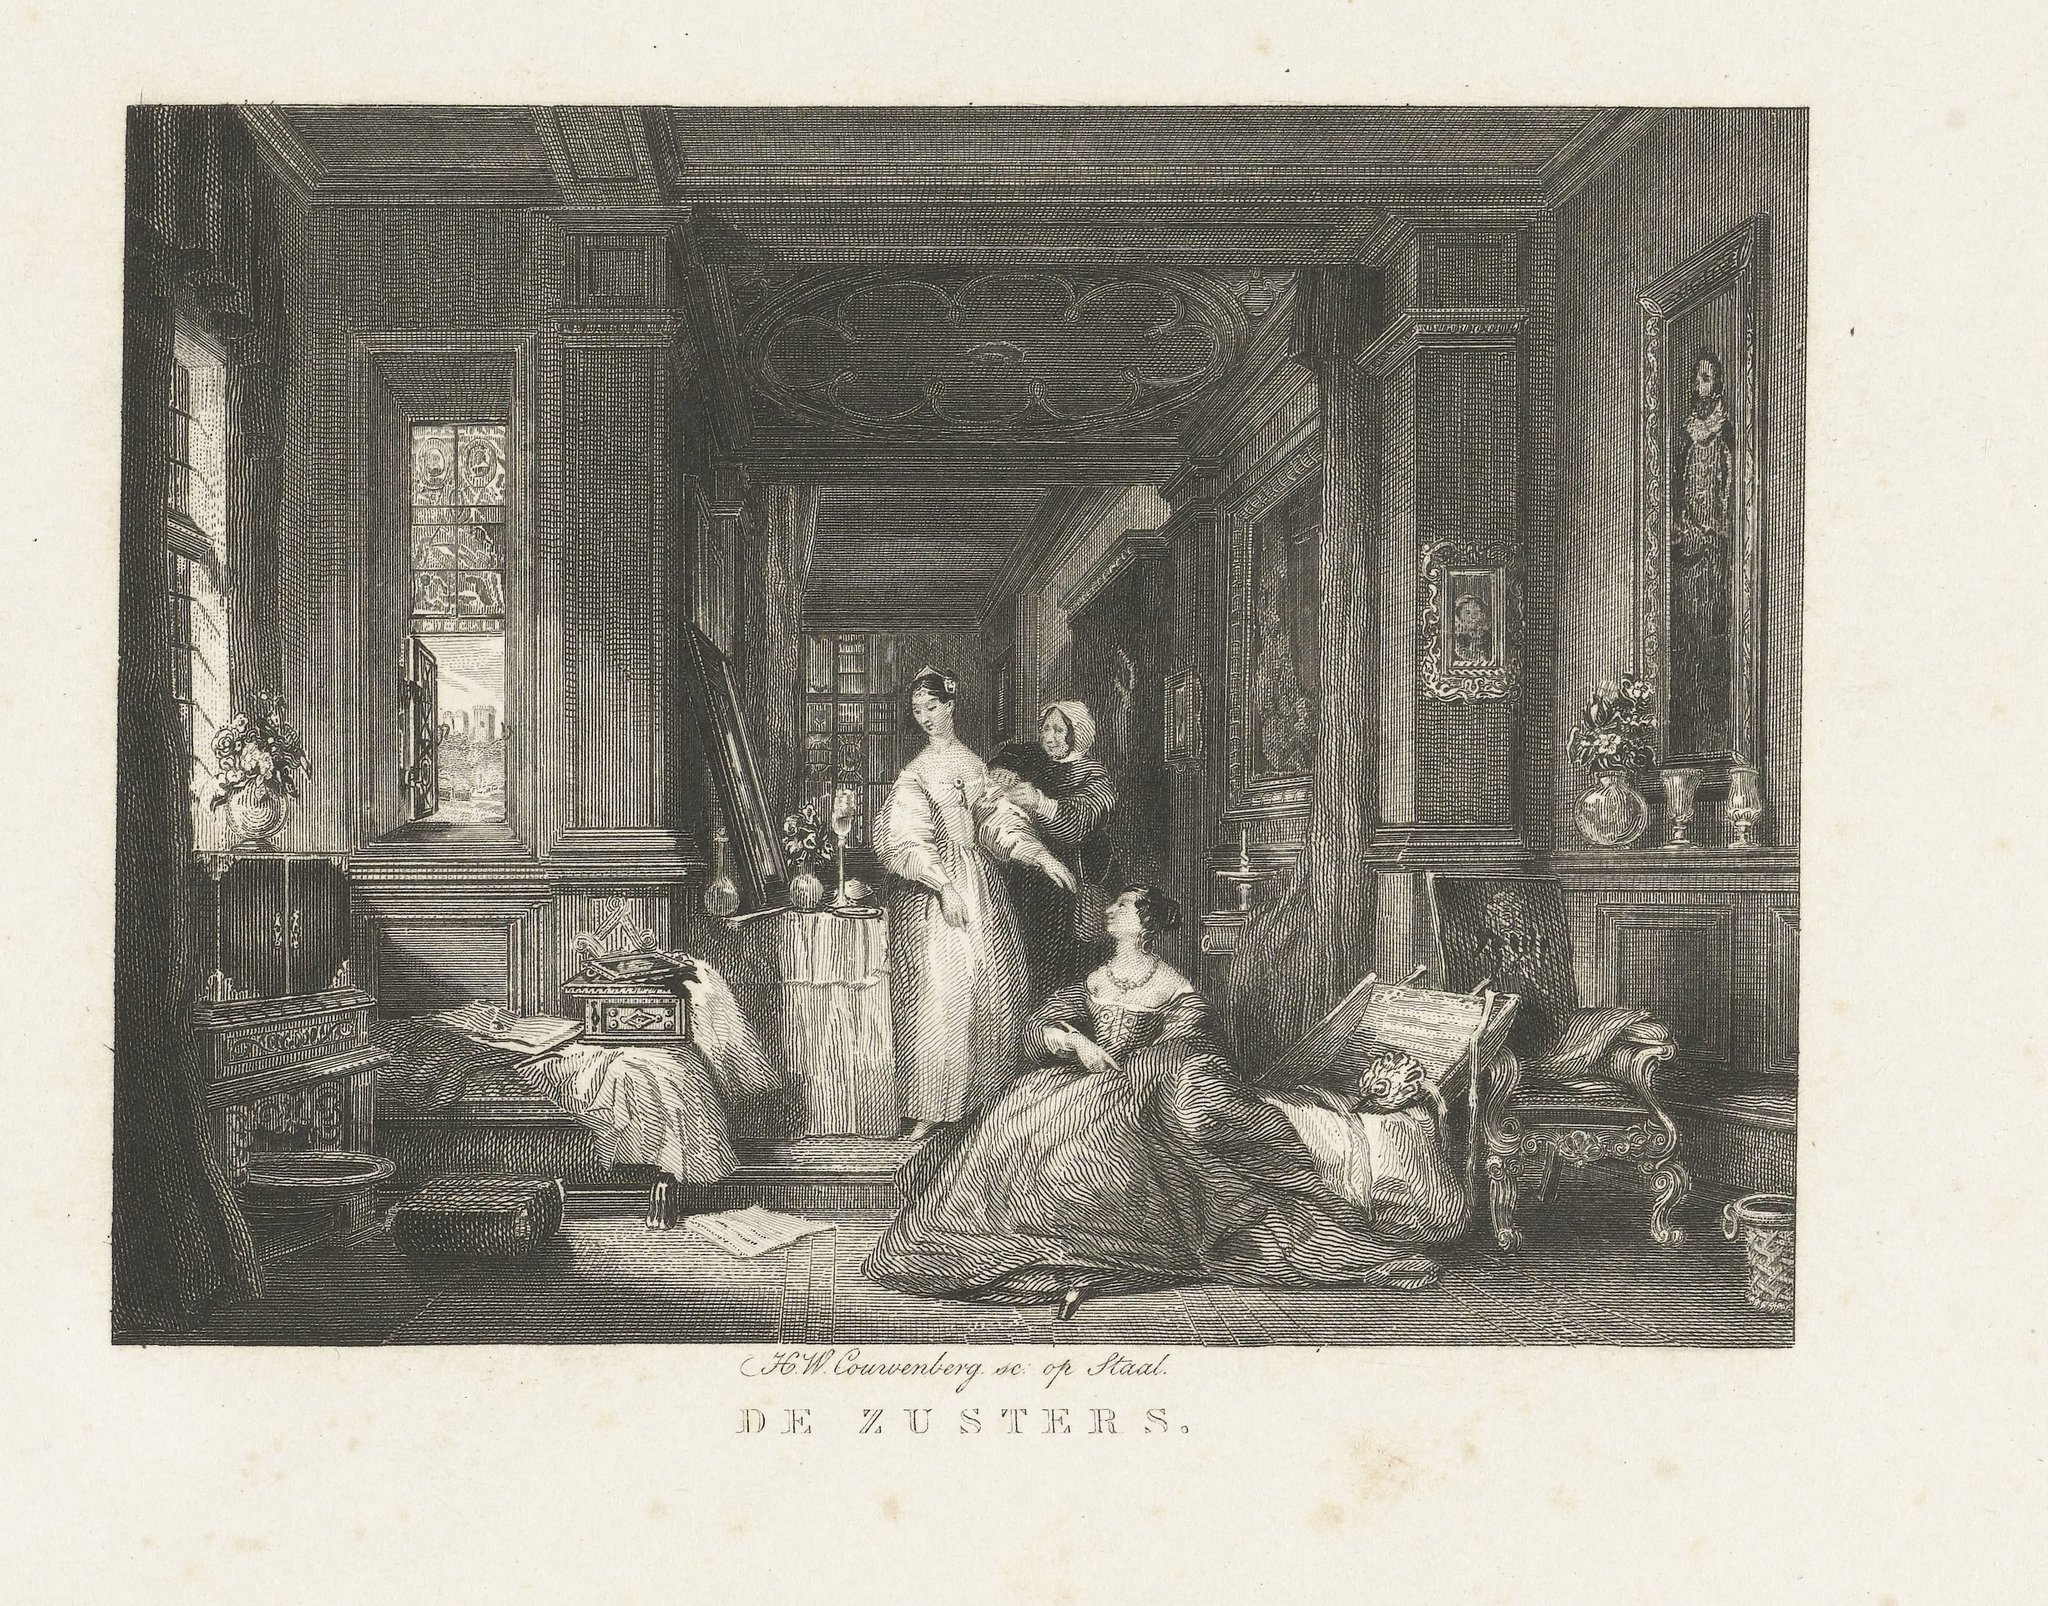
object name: book illustration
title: De zusters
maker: henricus wilhelmus couwenberg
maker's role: draughtsman, print maker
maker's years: 1814-1845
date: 1838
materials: paper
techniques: engraving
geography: amsterdam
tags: mirror, dress, gown (+ women's clothes), dress, gown (+ fitting ~ home making of clothes)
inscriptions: collector's mark: Lugt 2228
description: Twee zusters in een woonvertrek. De ene zuster krijgt een nieuwe jurk aangemeten. Ze kijkt naar een spiegel die op een tafel staat. Een bediende zet naalden in de mouw. De andere zuster zit naast een kist met stof en toont haar zuster de mogelijkheden.